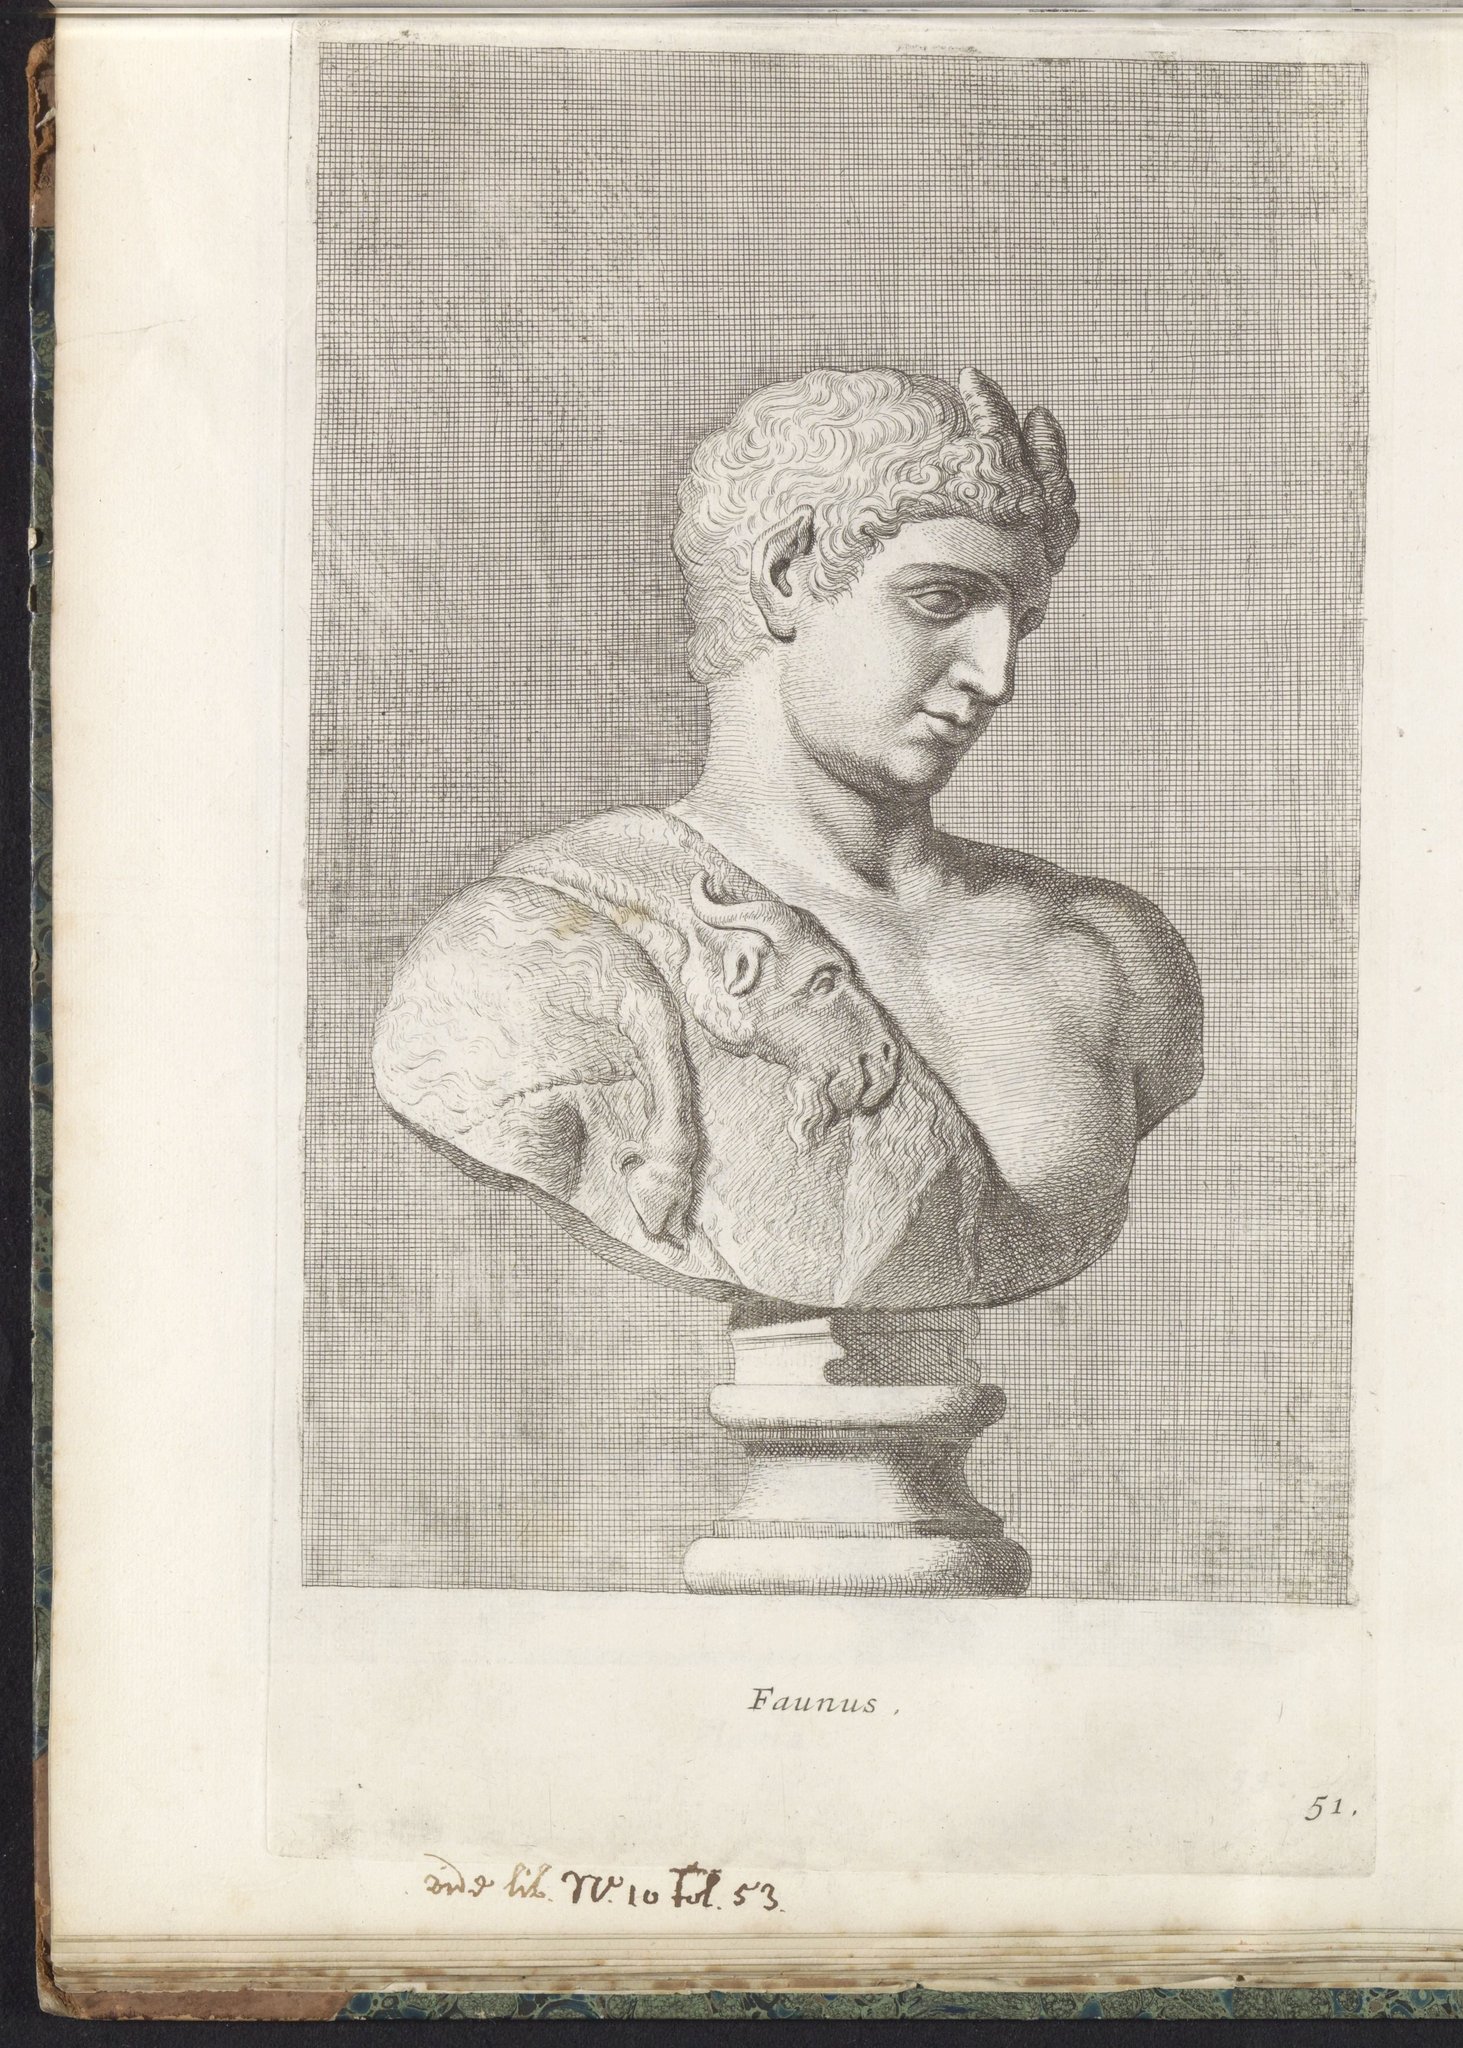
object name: print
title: Faunus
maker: hubert quellinus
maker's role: print maker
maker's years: 1619-1687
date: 1646-1670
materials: paper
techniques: engraving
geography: antwerp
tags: (story of) pan, piece of sculpture, reproduction of a piece of sculpture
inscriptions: inscription: ‘Vide lib. No. 10 fol. 53’, number: ‘65’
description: Klassieke buste van Pan met de huid van een bok over zijn schouder en twee hoorns op zijn hoofd. De prent maakt deel uit van een album met een serie prenten naar de sculpturen in de verzameling van Gerard Reynst.